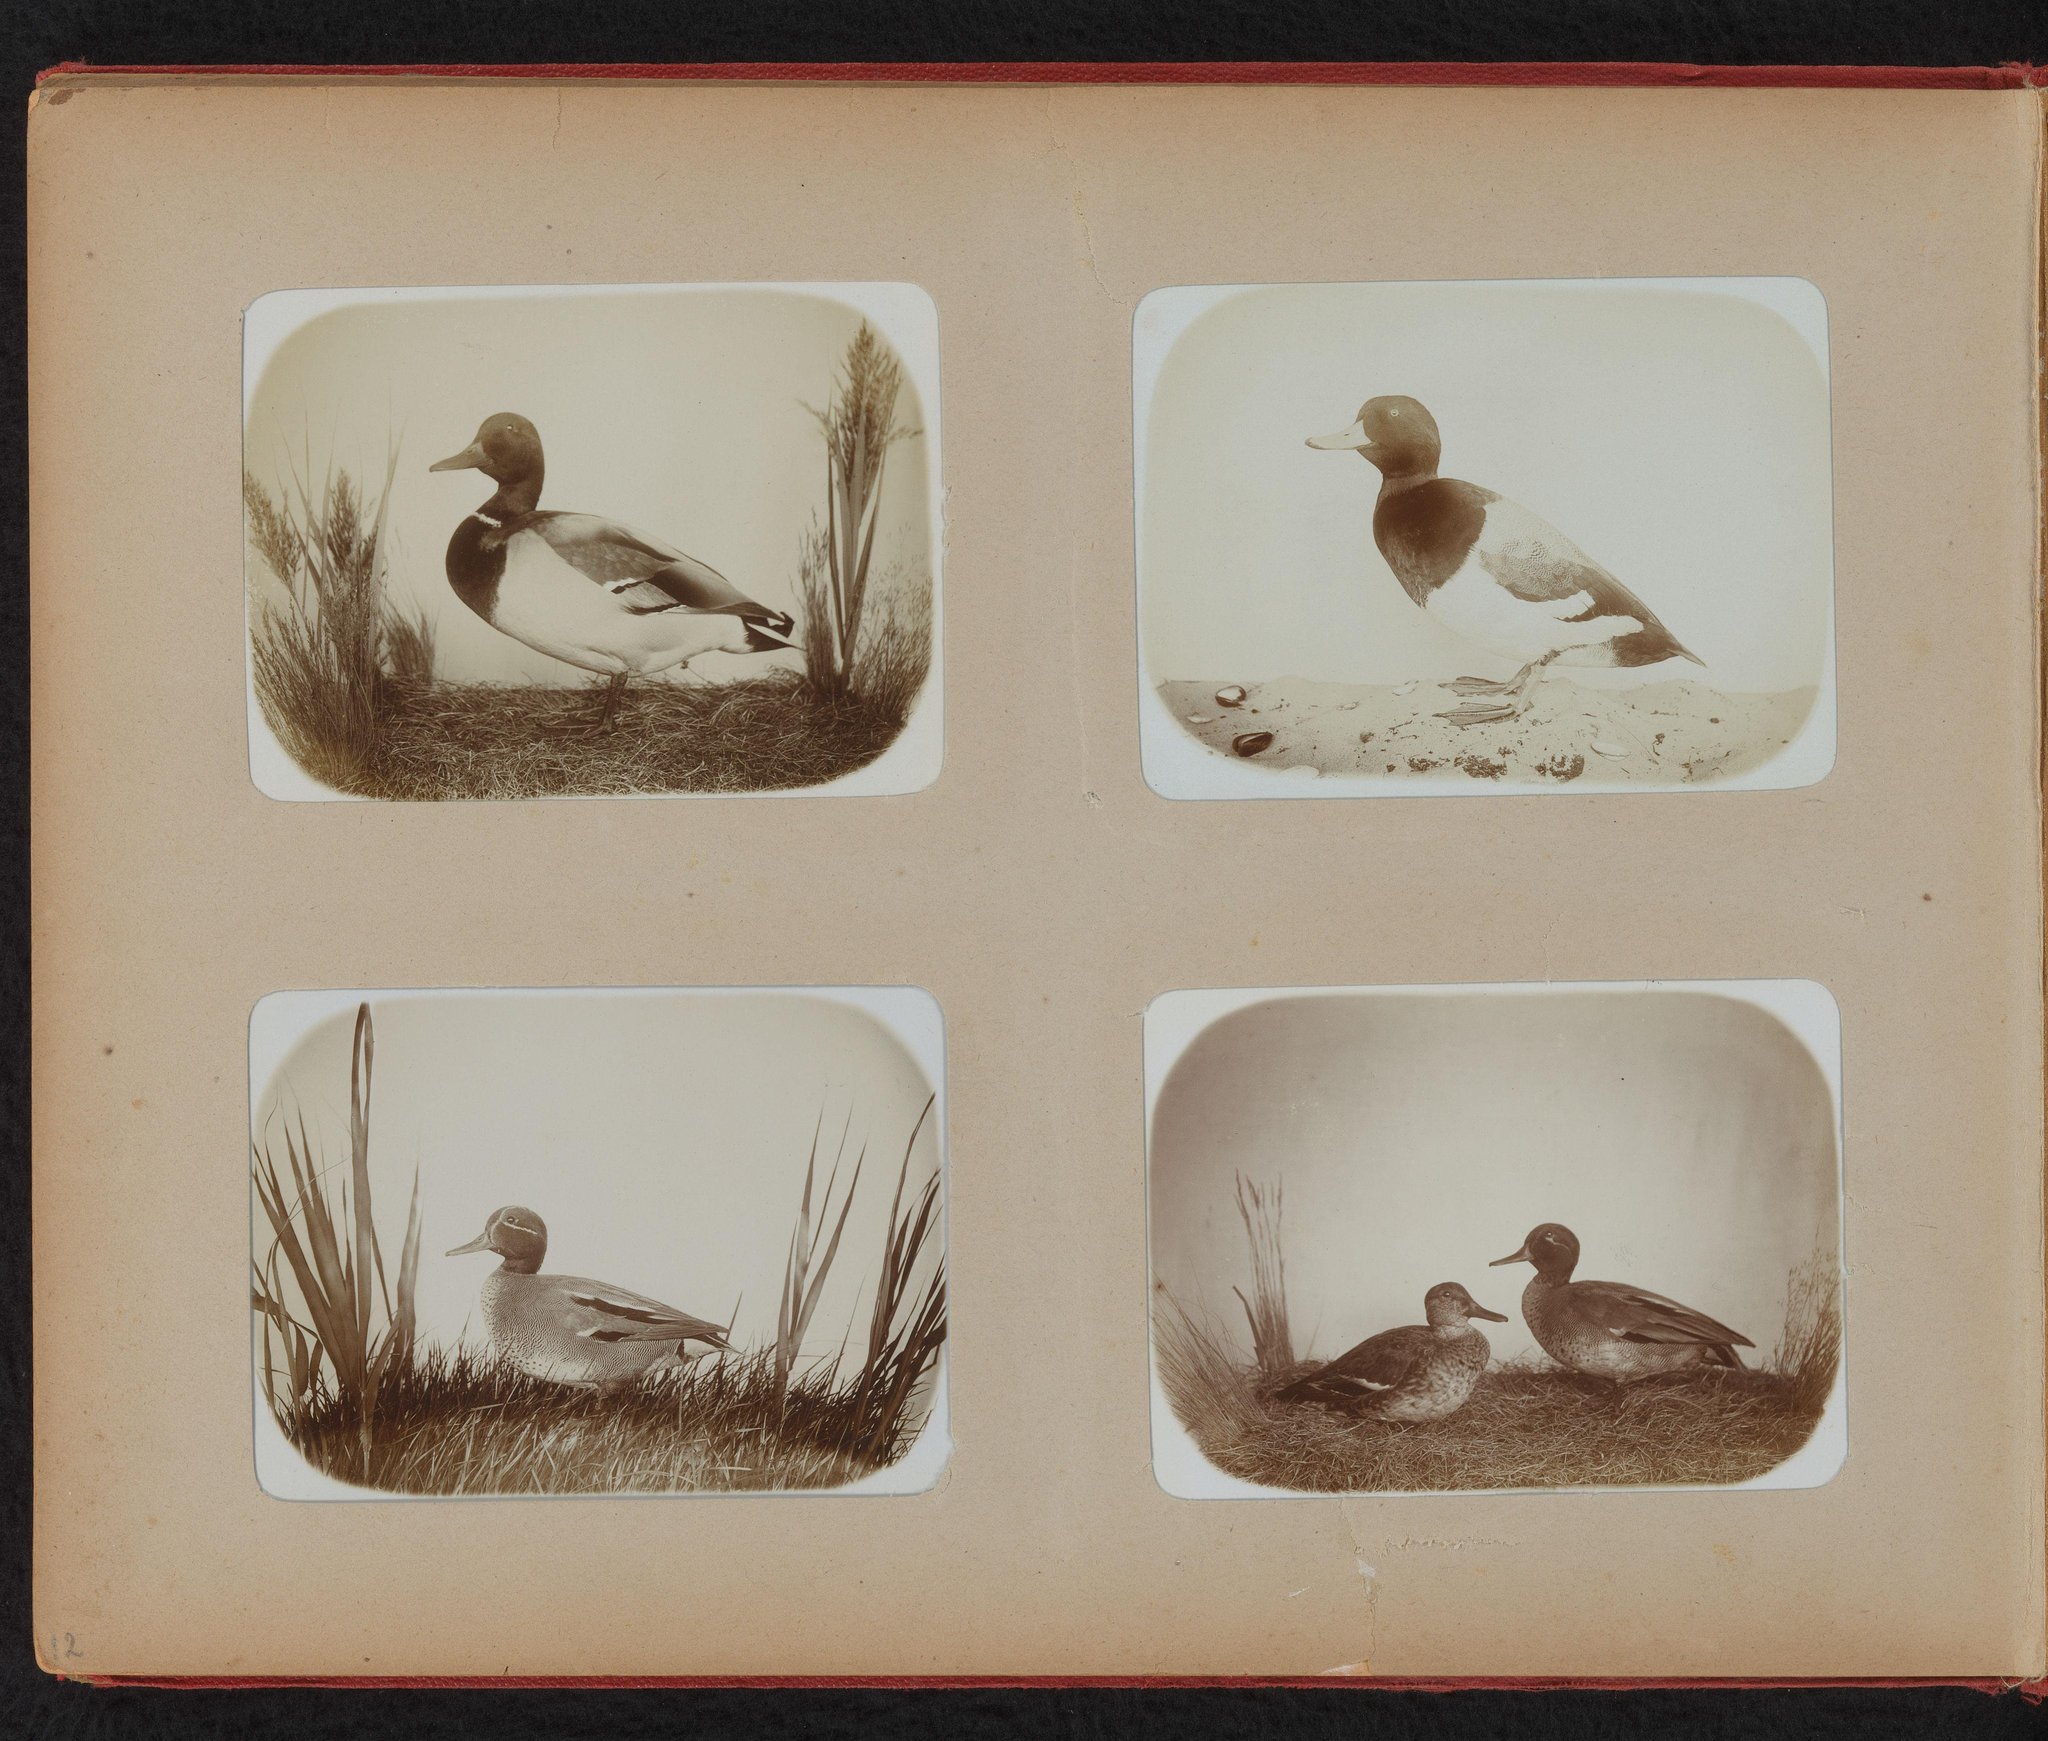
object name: photograph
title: Opgezette wilde eenden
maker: Anonymous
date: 1895-1910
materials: paper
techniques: gelatin silver print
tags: water-birds: duck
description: Deze foto's maken deel uit van een album.